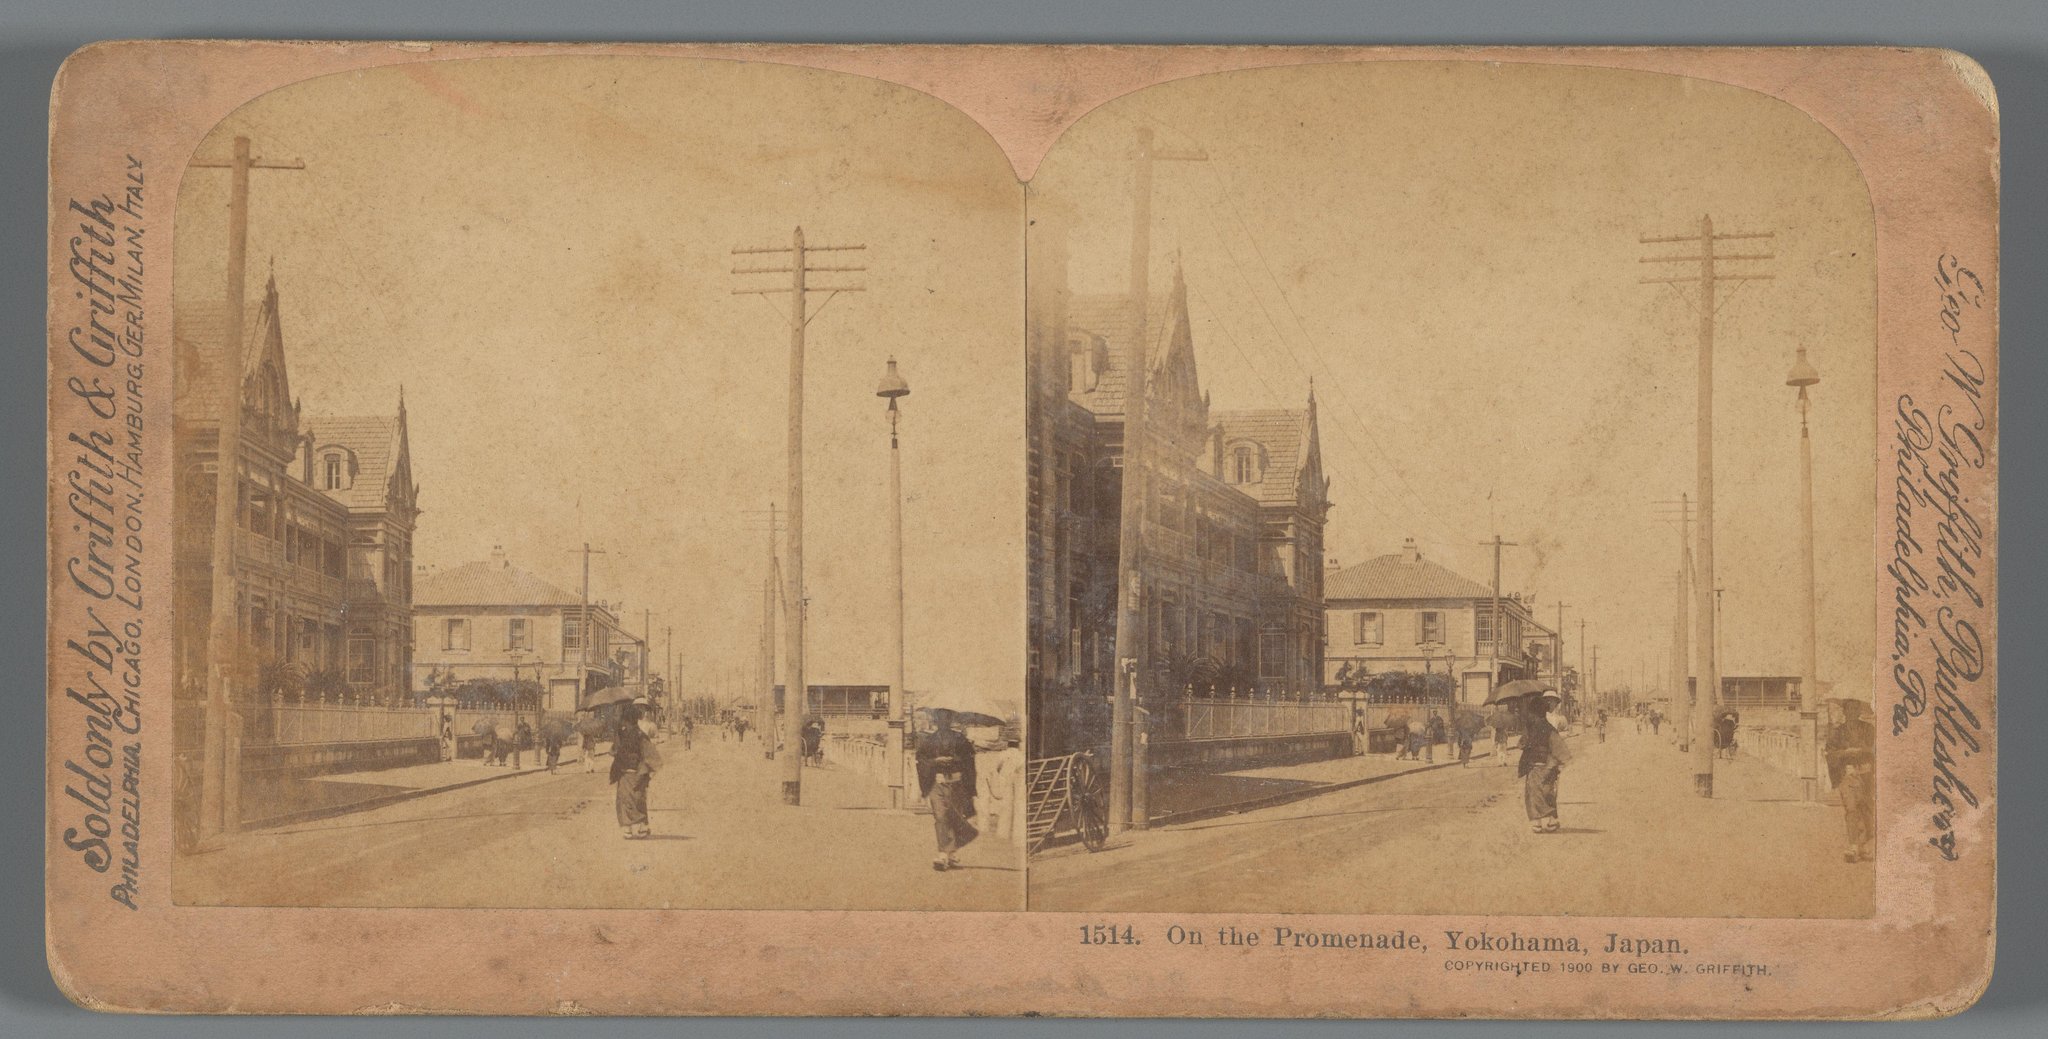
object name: stereograph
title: Straat in Yokohama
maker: Anonymous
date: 1900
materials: cardboard, paper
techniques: albumen print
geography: yokohama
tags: street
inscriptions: copyright notice: ‘COPYRIGHT 1900 BY GEORGE W. GRIFFITH.’, number: ‘1514.’